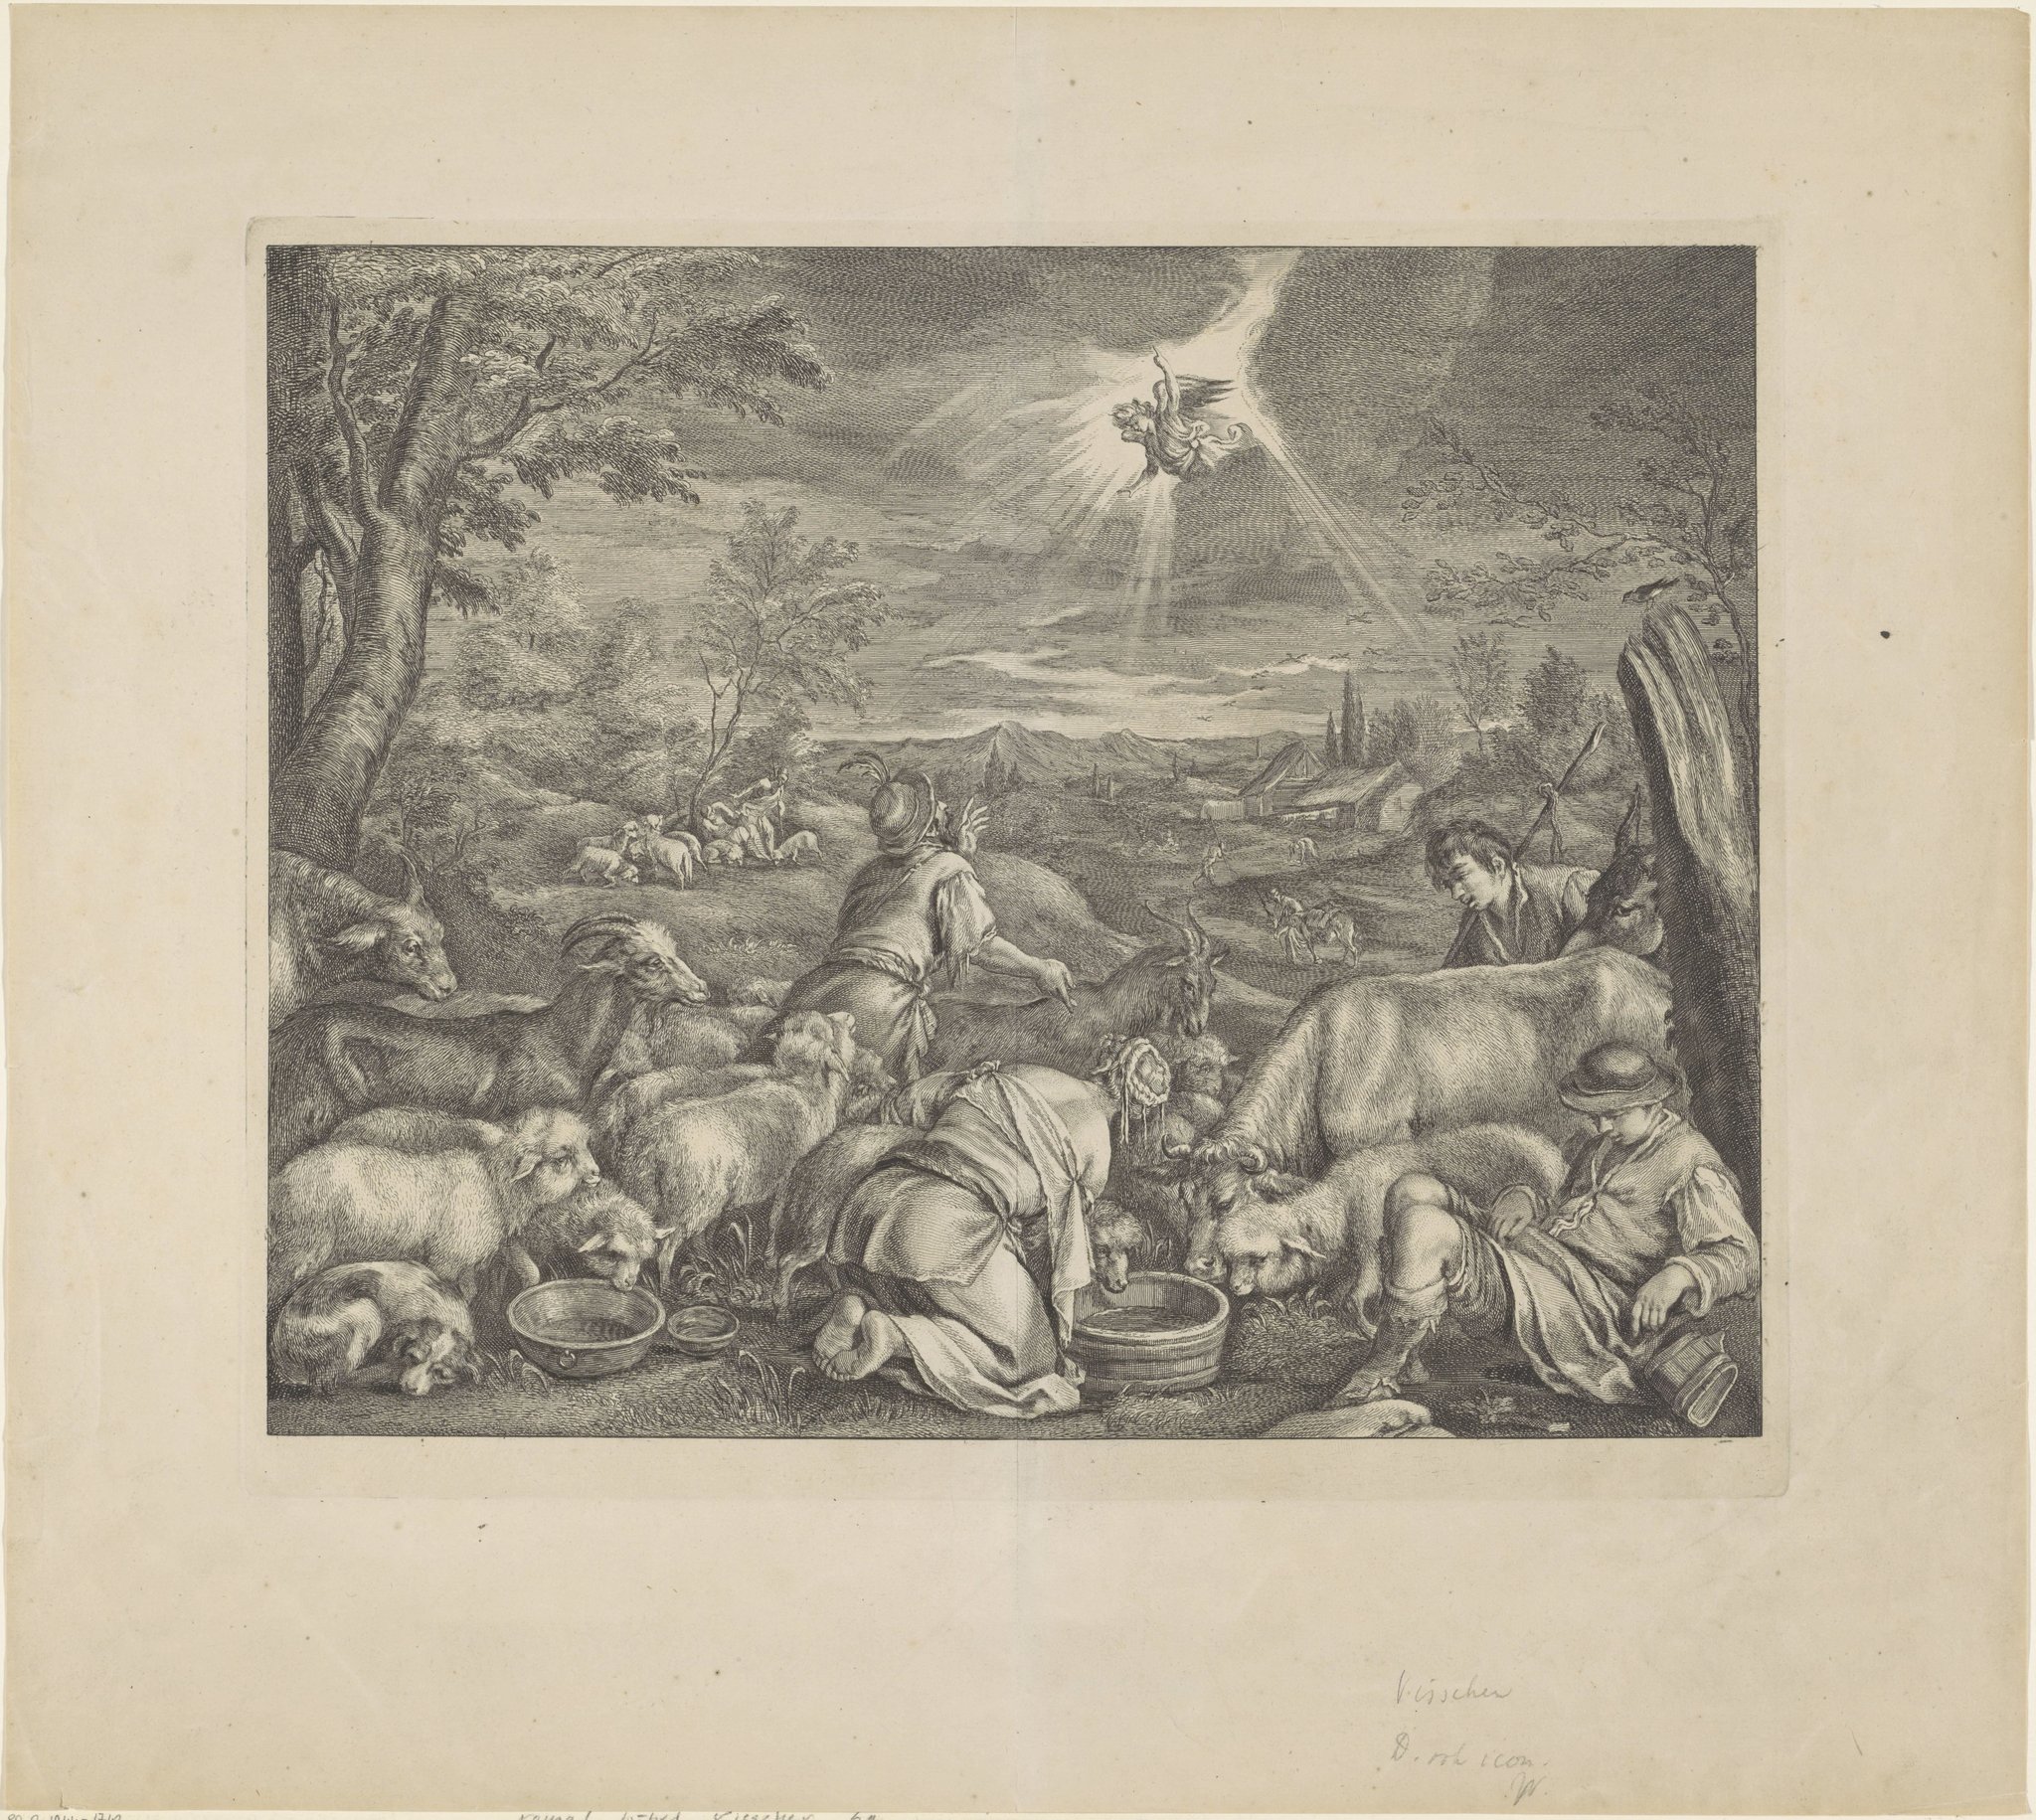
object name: print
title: Abraham vertrekt naar Sichem / Verkondiging aan de herders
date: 1638-1658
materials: paper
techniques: engraving, etching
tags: annunciation of christ's birth to the shepherds (and/or shepherdesses) at night; a host of singing angels in the air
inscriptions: collector's mark: Lugt 2228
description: De Amsterdamse uitgever Claes Jansz. Visscher (II) produceerde vanaf de jaren ’30 van de zeventiende eeuw grote Bijbelse prenten op zogenaamd royaal-formaat papier (ca. 480 x 580 mm). Na zijn dood in 1652 zette zijn zoon Nicolaes Visscher (I) het bedrijf voort en zo ook de uitgave van Royaalbijbelprenten. Toen Nicolaes in 1679 overleed nam zijn zoon Nicolaes Visscher (II) het bedrijf over en gaf kort hierna, omstreeks 1680, een fondslijst uit. Hierin worden 130 prenten met Bijbelse voorstellingen op royaalpapier beschreven (zie documentatie J. van der Waals). Complete prentbijbels op royaal-formaat werden door vader en zoon Nicolaes Visscher uitgegeven onder de titel Historiae Sacrae Veteris et Novi Testamenti. De bladen werden echter ook los verkocht en konden worden gecombineerd met Royaalbijbel-prenten van andere uitgevers. Verschillende Amsterdamse uitgevers brachten namelijk ook bijbelprenten op royaal-formaat uit, onder wie Clement de Jonghe en Cornelis Danckerts. De door de firma Visscher uitgegeven prenten zijn veelal vervaardigd door anonieme prentmakers naar voorbeeld van verschillende zestiende- en zeventiende-eeuwse Bijbelse prenten en prentreeksen. Veelal moesten de composities worden aangepast aan het grotere en langgerekte royaal-formaat. Daarnaast zijn er ook grote bladen van bekende prentmakers zoals Jan van Londerseel, Pieter Nolpe, Jacques de Gheyn (II) en Jan Harmensz. Muller opgenomen in de categorie ‘Bybelsche Figuren, op Royaal-bladen’ in de fondslijst van Visscher. Prent mogelijk gebruikt in: Historiae Sacrae Veteris et Novi Testamenti (Royaalbijbel). Amsterdam: Nicolaes Visscher (I) en (II), [1652-1702]. In de fondslijst van Nicolaes Visscher II (ca. 1680) is het onderwerp van deze prent onder de titel 'Bybelsche Figuren, op Royaal-bladen. bestaande uyt de volgende historien.' als volgt genummerd: 69.